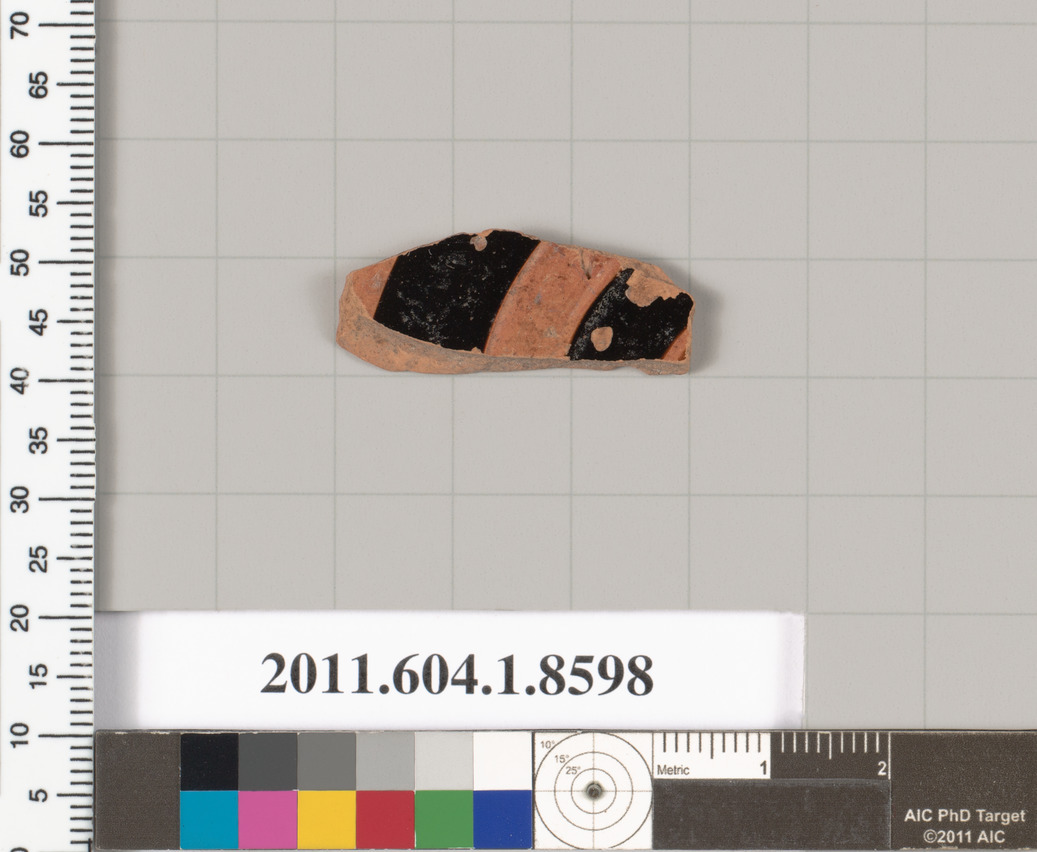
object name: kylix fragment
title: Terracotta fragment of a stemless kylix (drinking cup)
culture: greek, attic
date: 460-450 BCE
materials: terracotta